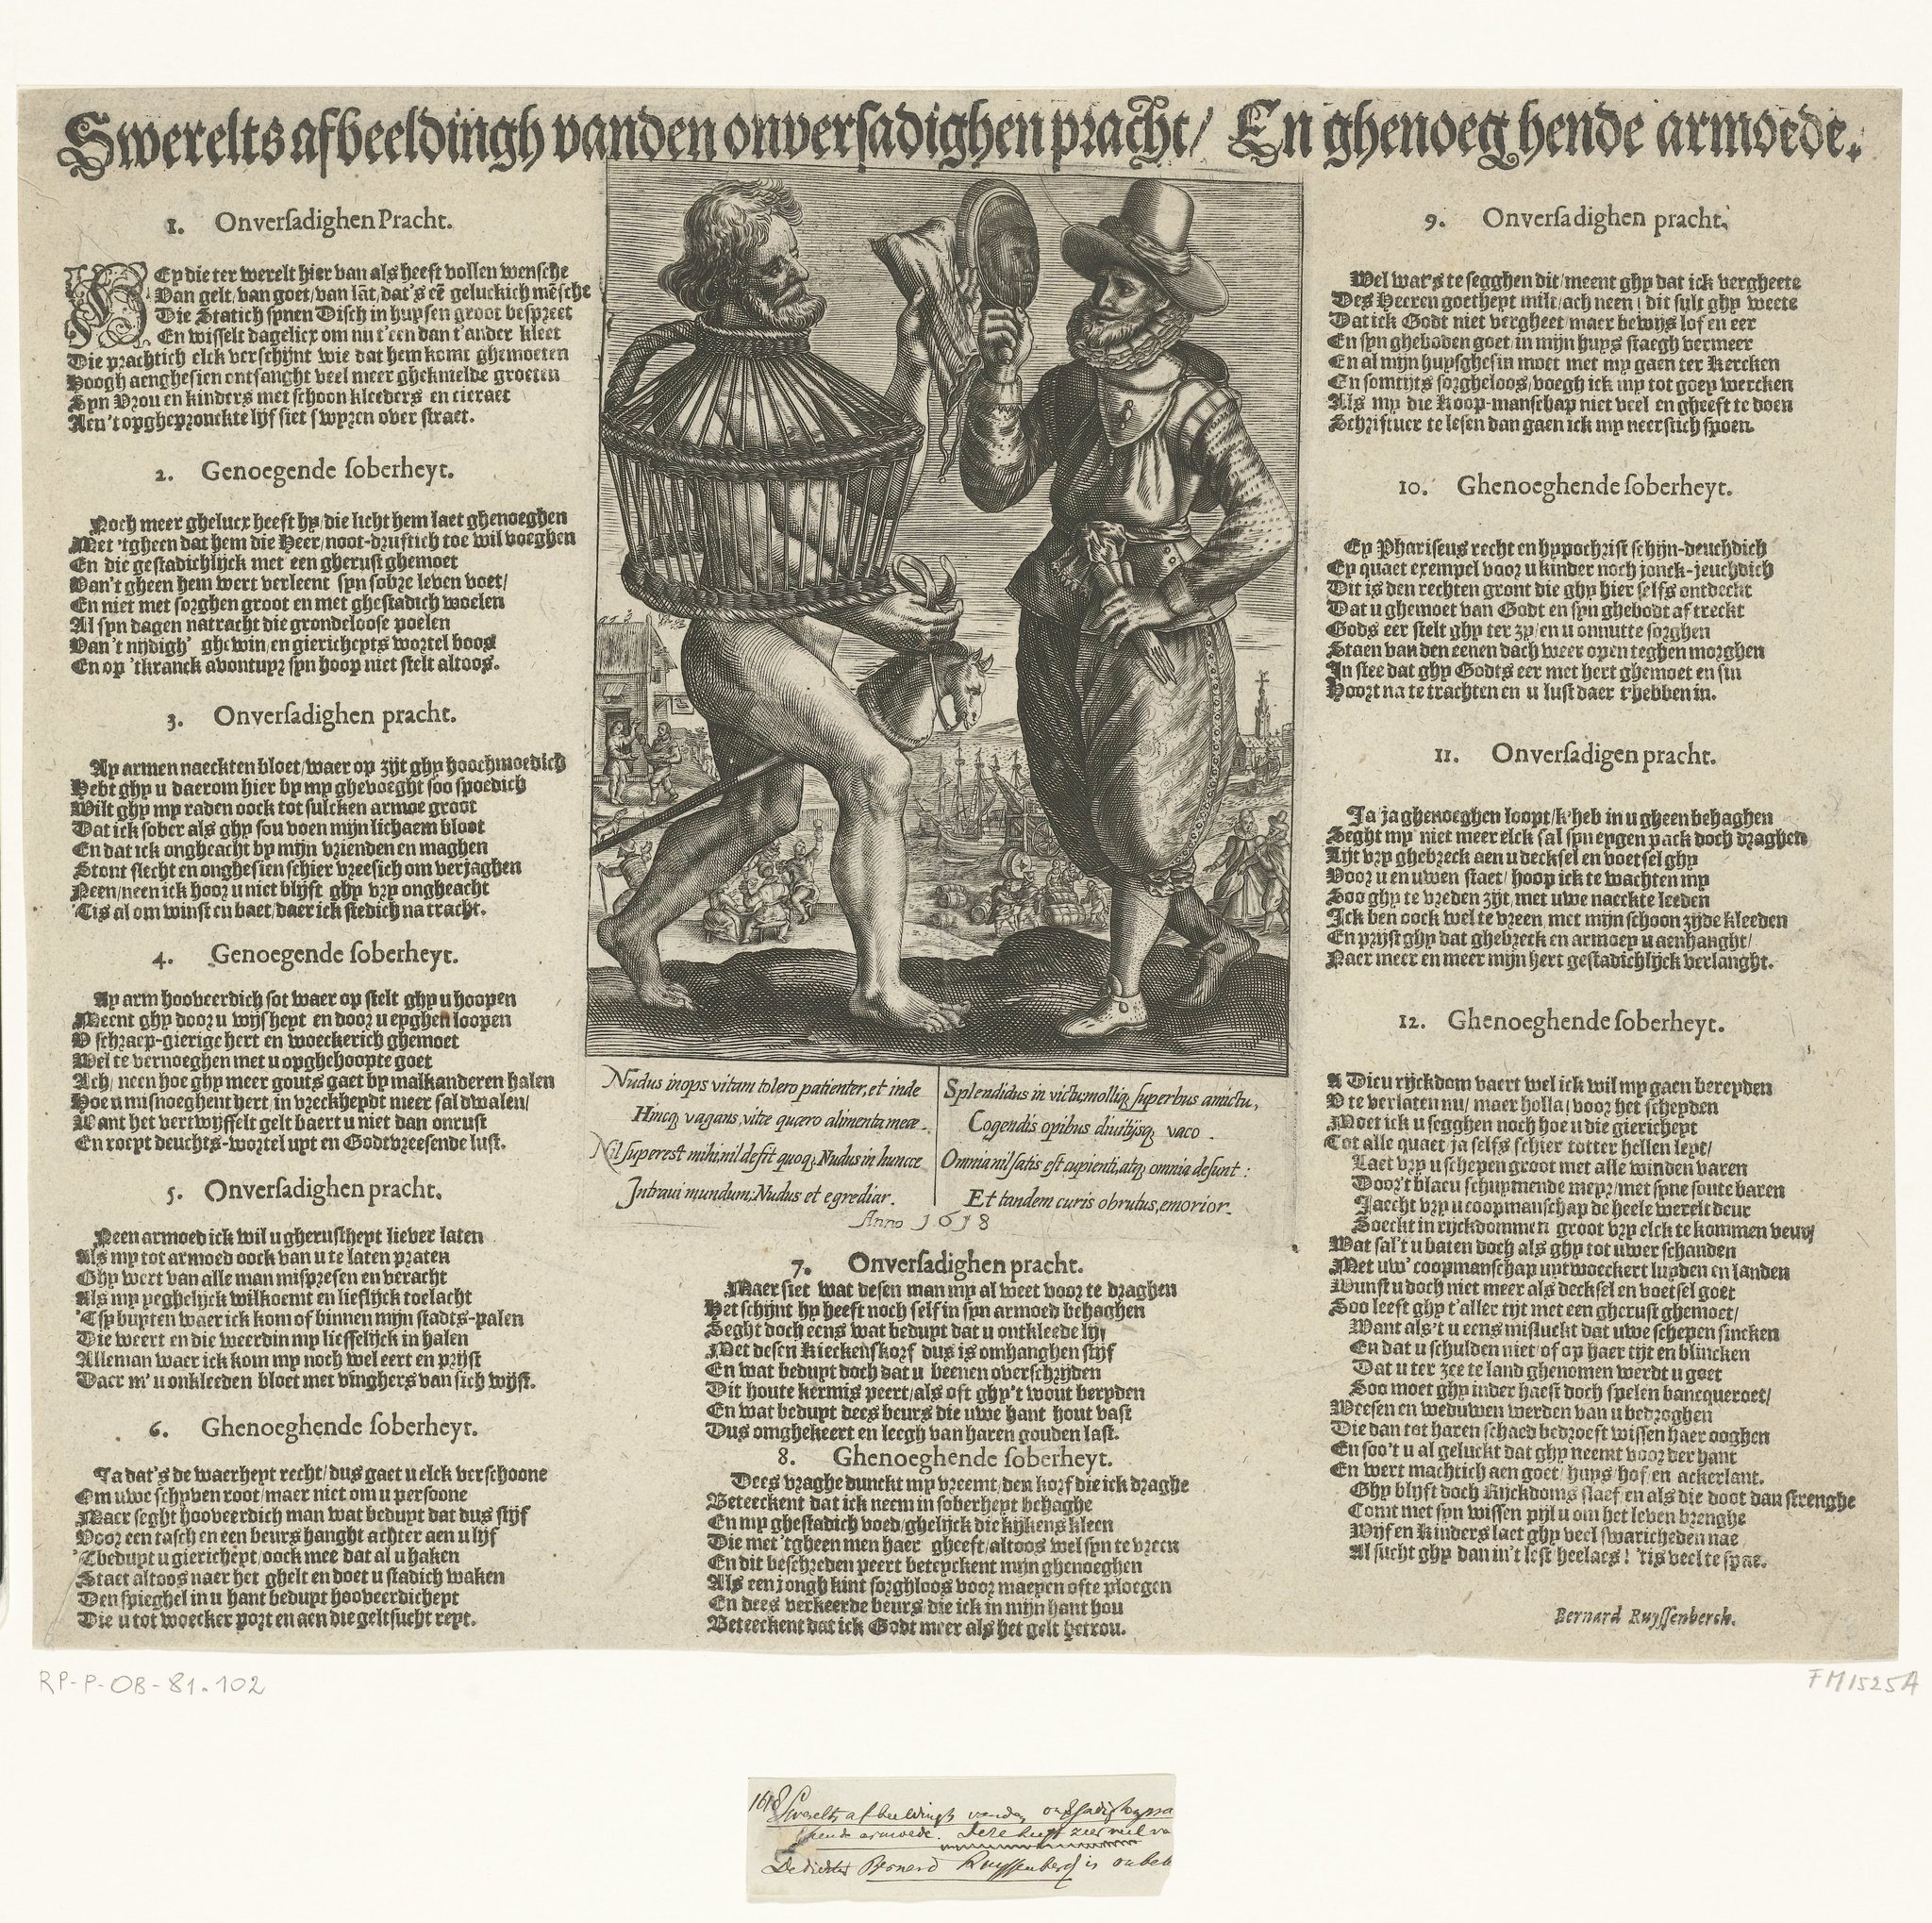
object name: cartoon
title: Swerelts afbeeldingh vanden onversadighen pracht / En ghenoeghende armoede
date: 1618-1625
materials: paper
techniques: engraving, letterpress printing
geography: low countries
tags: contrast between rich and poor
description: Spotprent op de onverzadigbare rijkdom en de bevredigende armoede, 1618. Tegenstelling tussen een naakte man slechts gekleed in een rieten vogelkooi rijdend op een stokpaard en een rijk en modieus geklede man die zichzelf in een handspiegel bekijkt. Op de achtergrond drinken en feesten voor een herberg en kooplieden in een havenstad. Met onderschrift van 2 keer 4 regels in het Latijn. De plaat gedrukt op een blad met verzen genummerd 1-12 met een samenspraak tussen Onversadighen Pracht en Genoegende soberheyt.